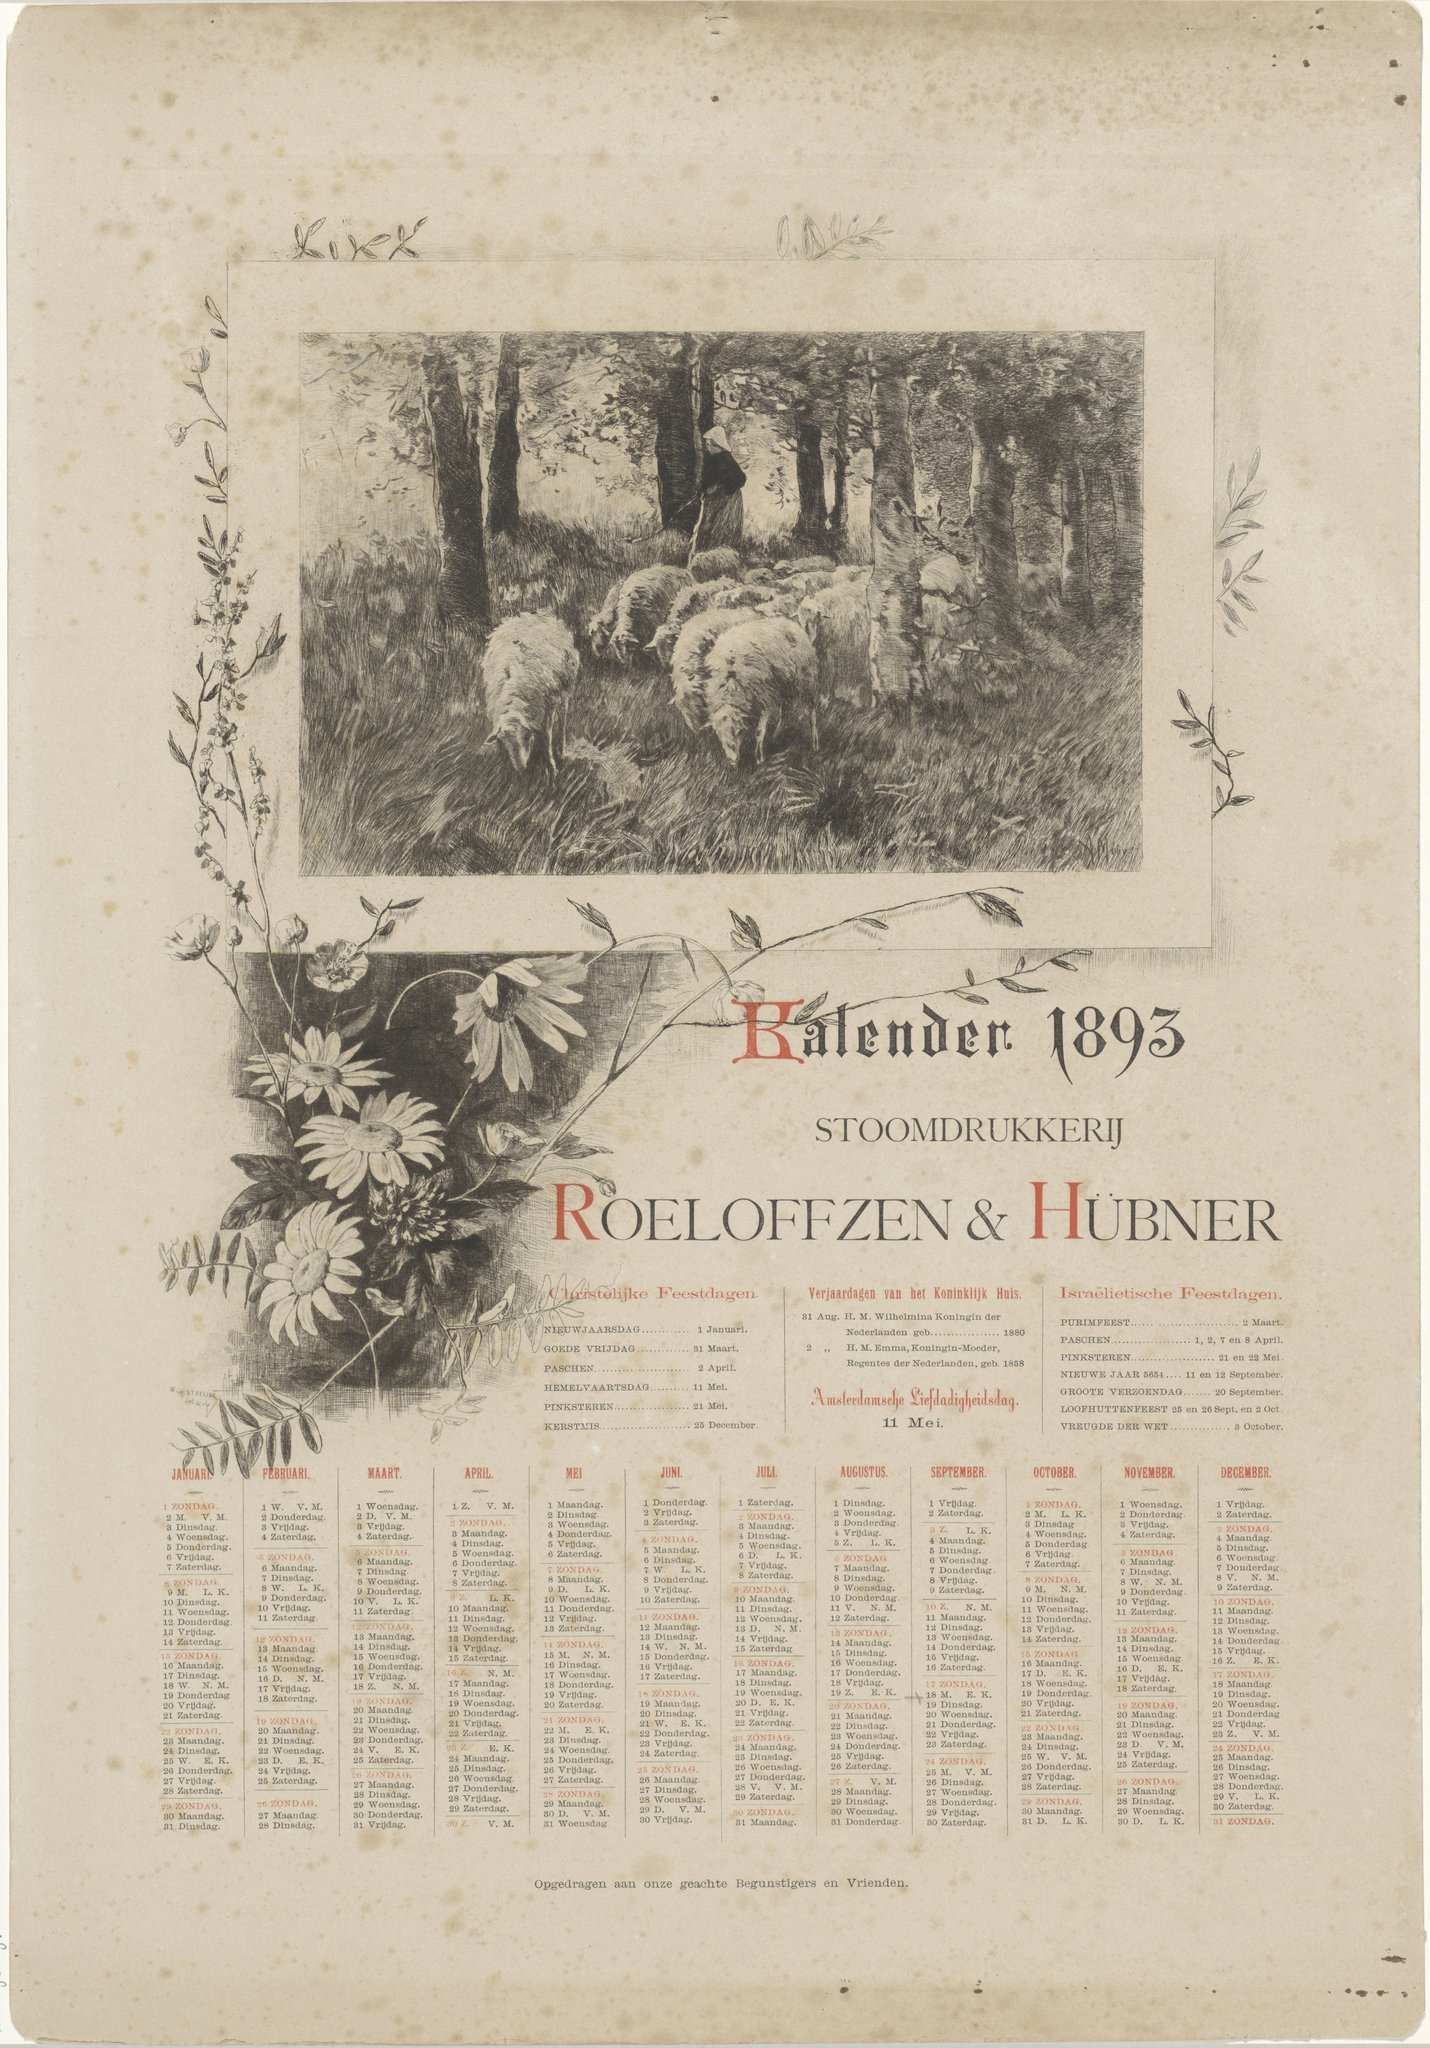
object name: calendar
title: Kalender 1893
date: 1892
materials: paper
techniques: etching, letterpress printing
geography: amsterdam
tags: flowers, herd, flock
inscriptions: collector's mark: Lugt 2233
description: Bovenaan een voorstelling van een herderin met een kudde schapen. Linksonder en langs de randen van de voorstelling bloemen.